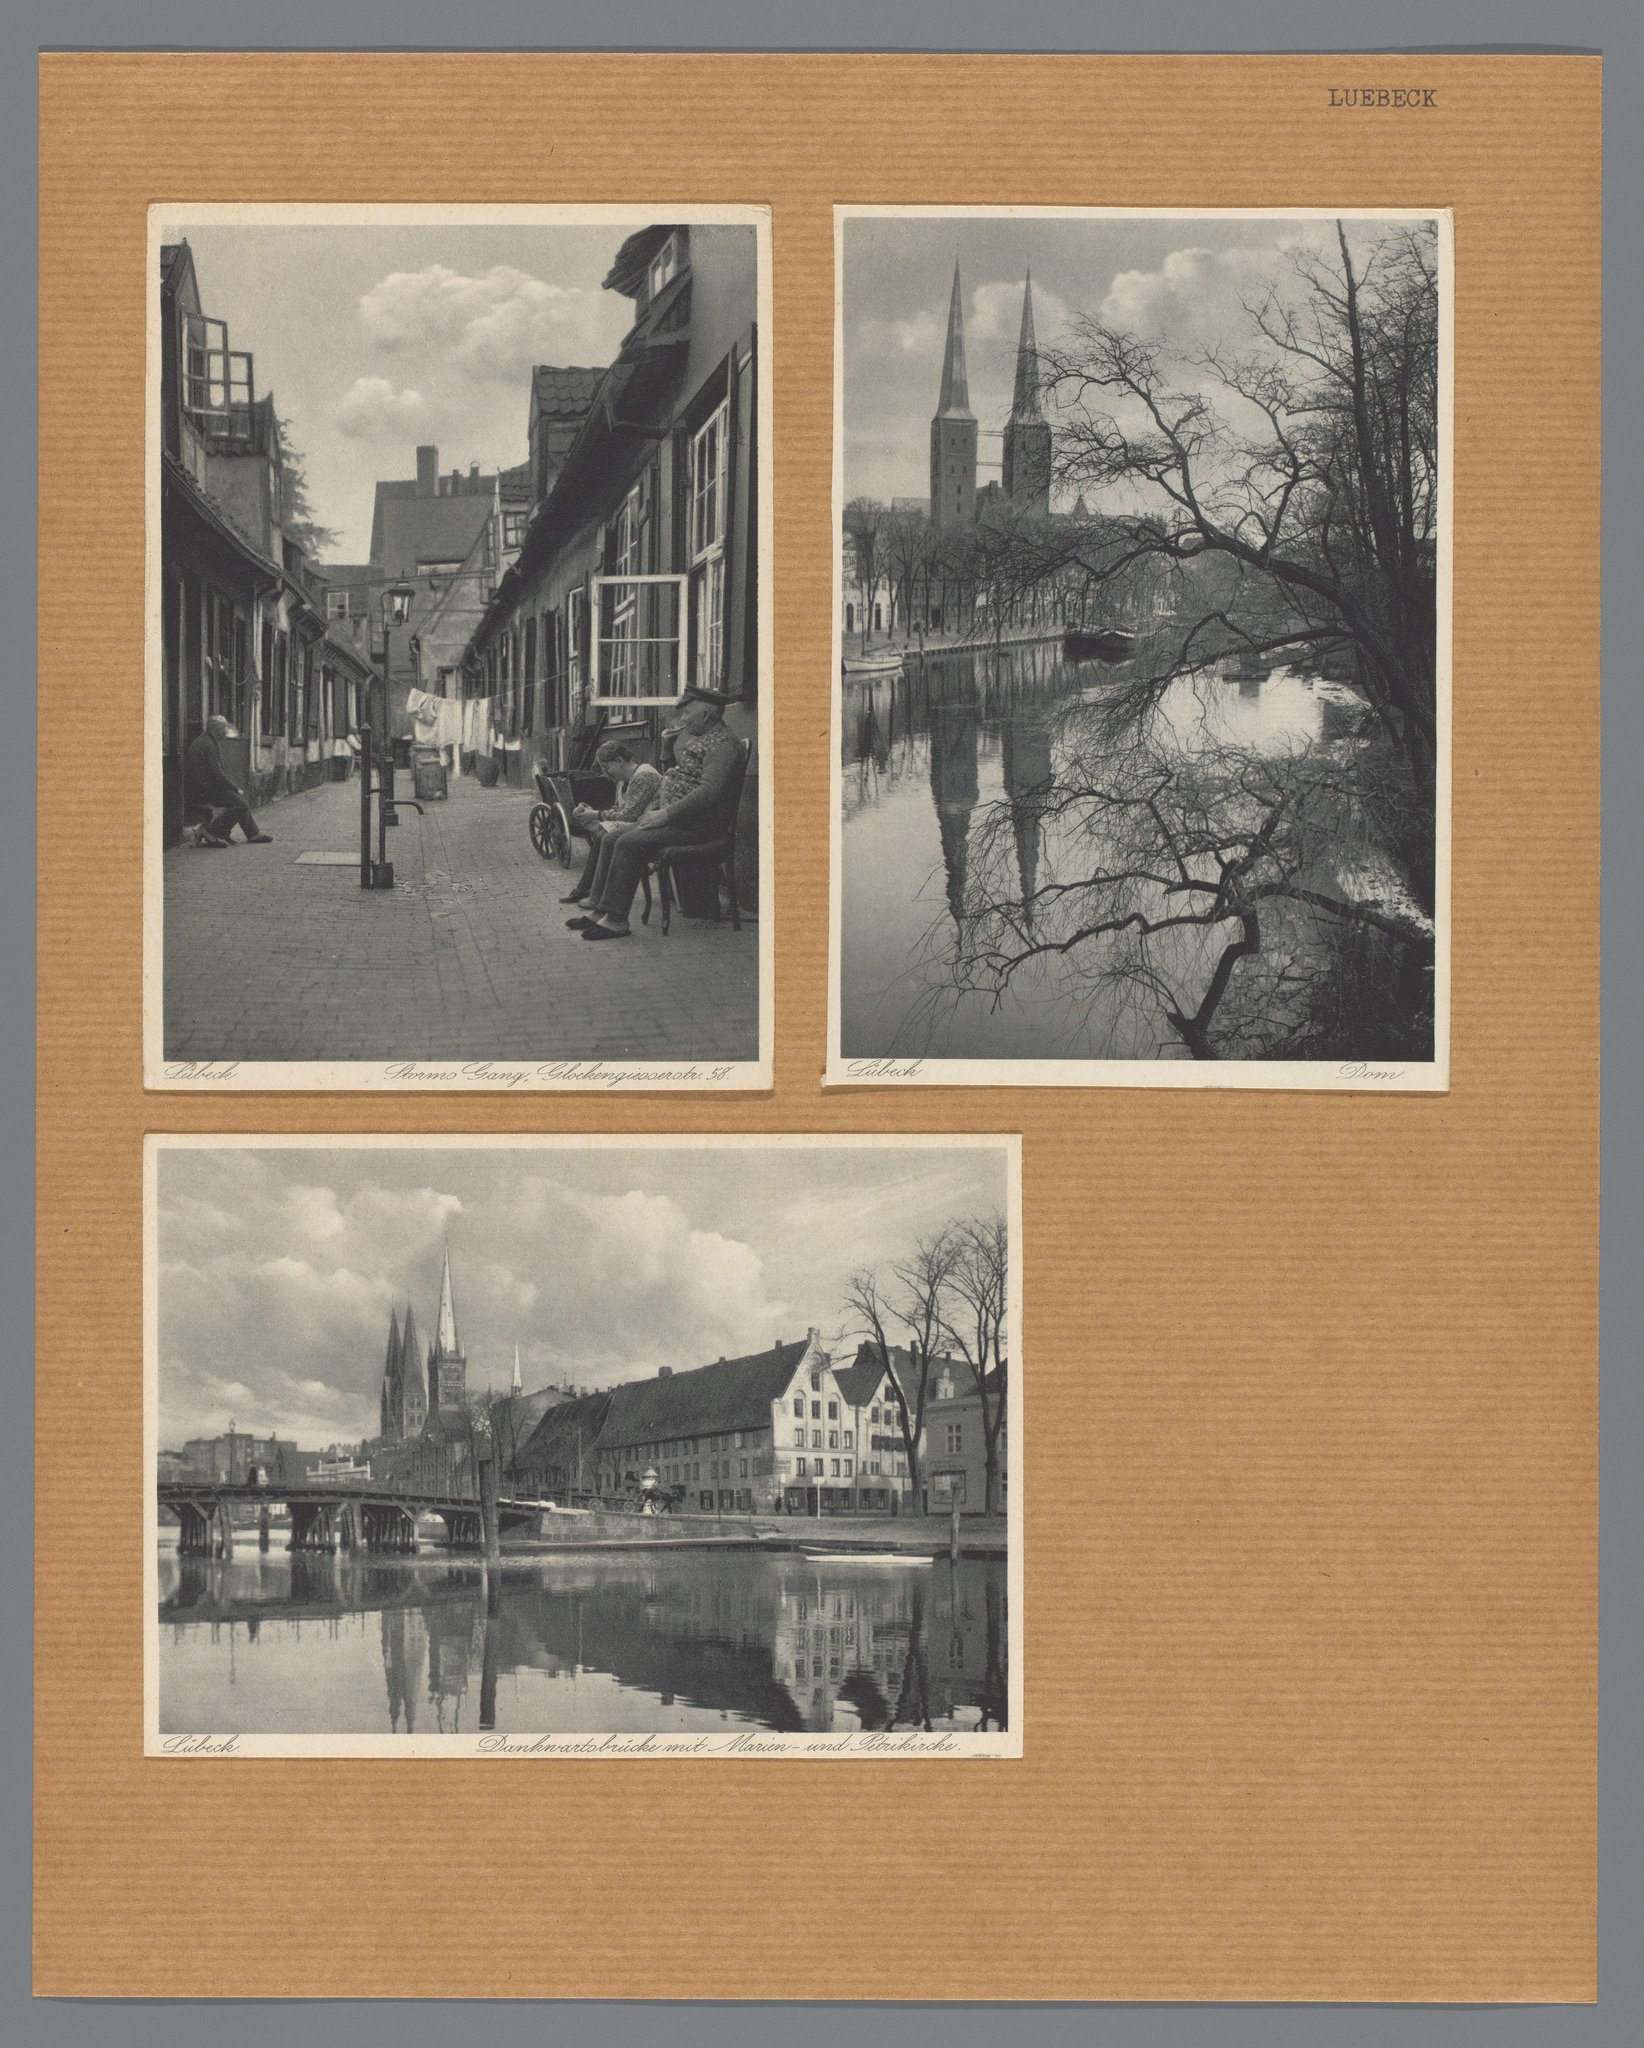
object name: photograph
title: Lindau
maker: Anonymous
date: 1880-1920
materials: photographic support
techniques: rotogravure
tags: lindau im bodensee